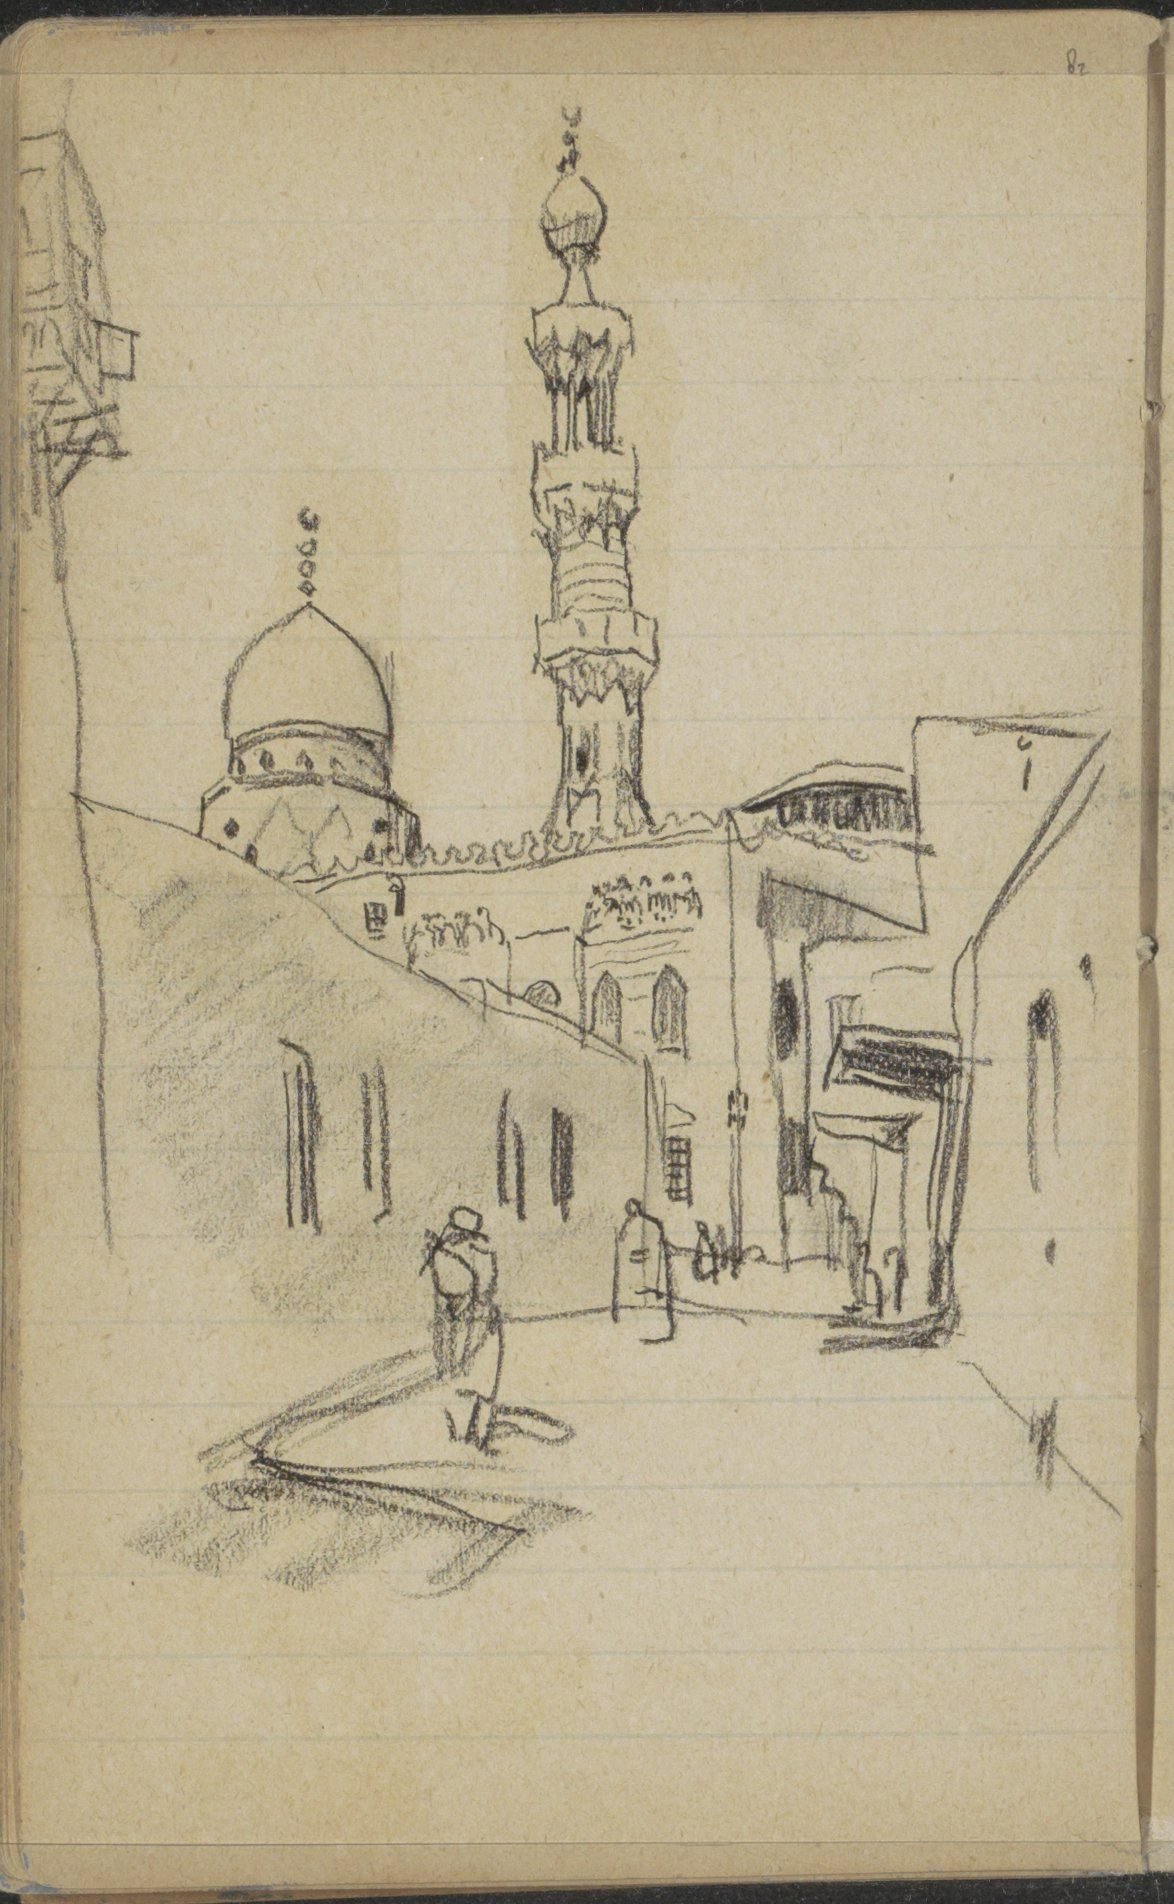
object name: sketchbook leaf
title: Straat in Caïro, met uitzicht op de Al-Rifai moskee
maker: marius bauer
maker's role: draughtsman, print maker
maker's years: 1867-1932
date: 1894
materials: chalk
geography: cairo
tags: temple, shrine ~ islam, mohammedanism, street (+ city(-scape) with figures, staffage)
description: Pagina 82 uit een schetsboek met 48 bladen.